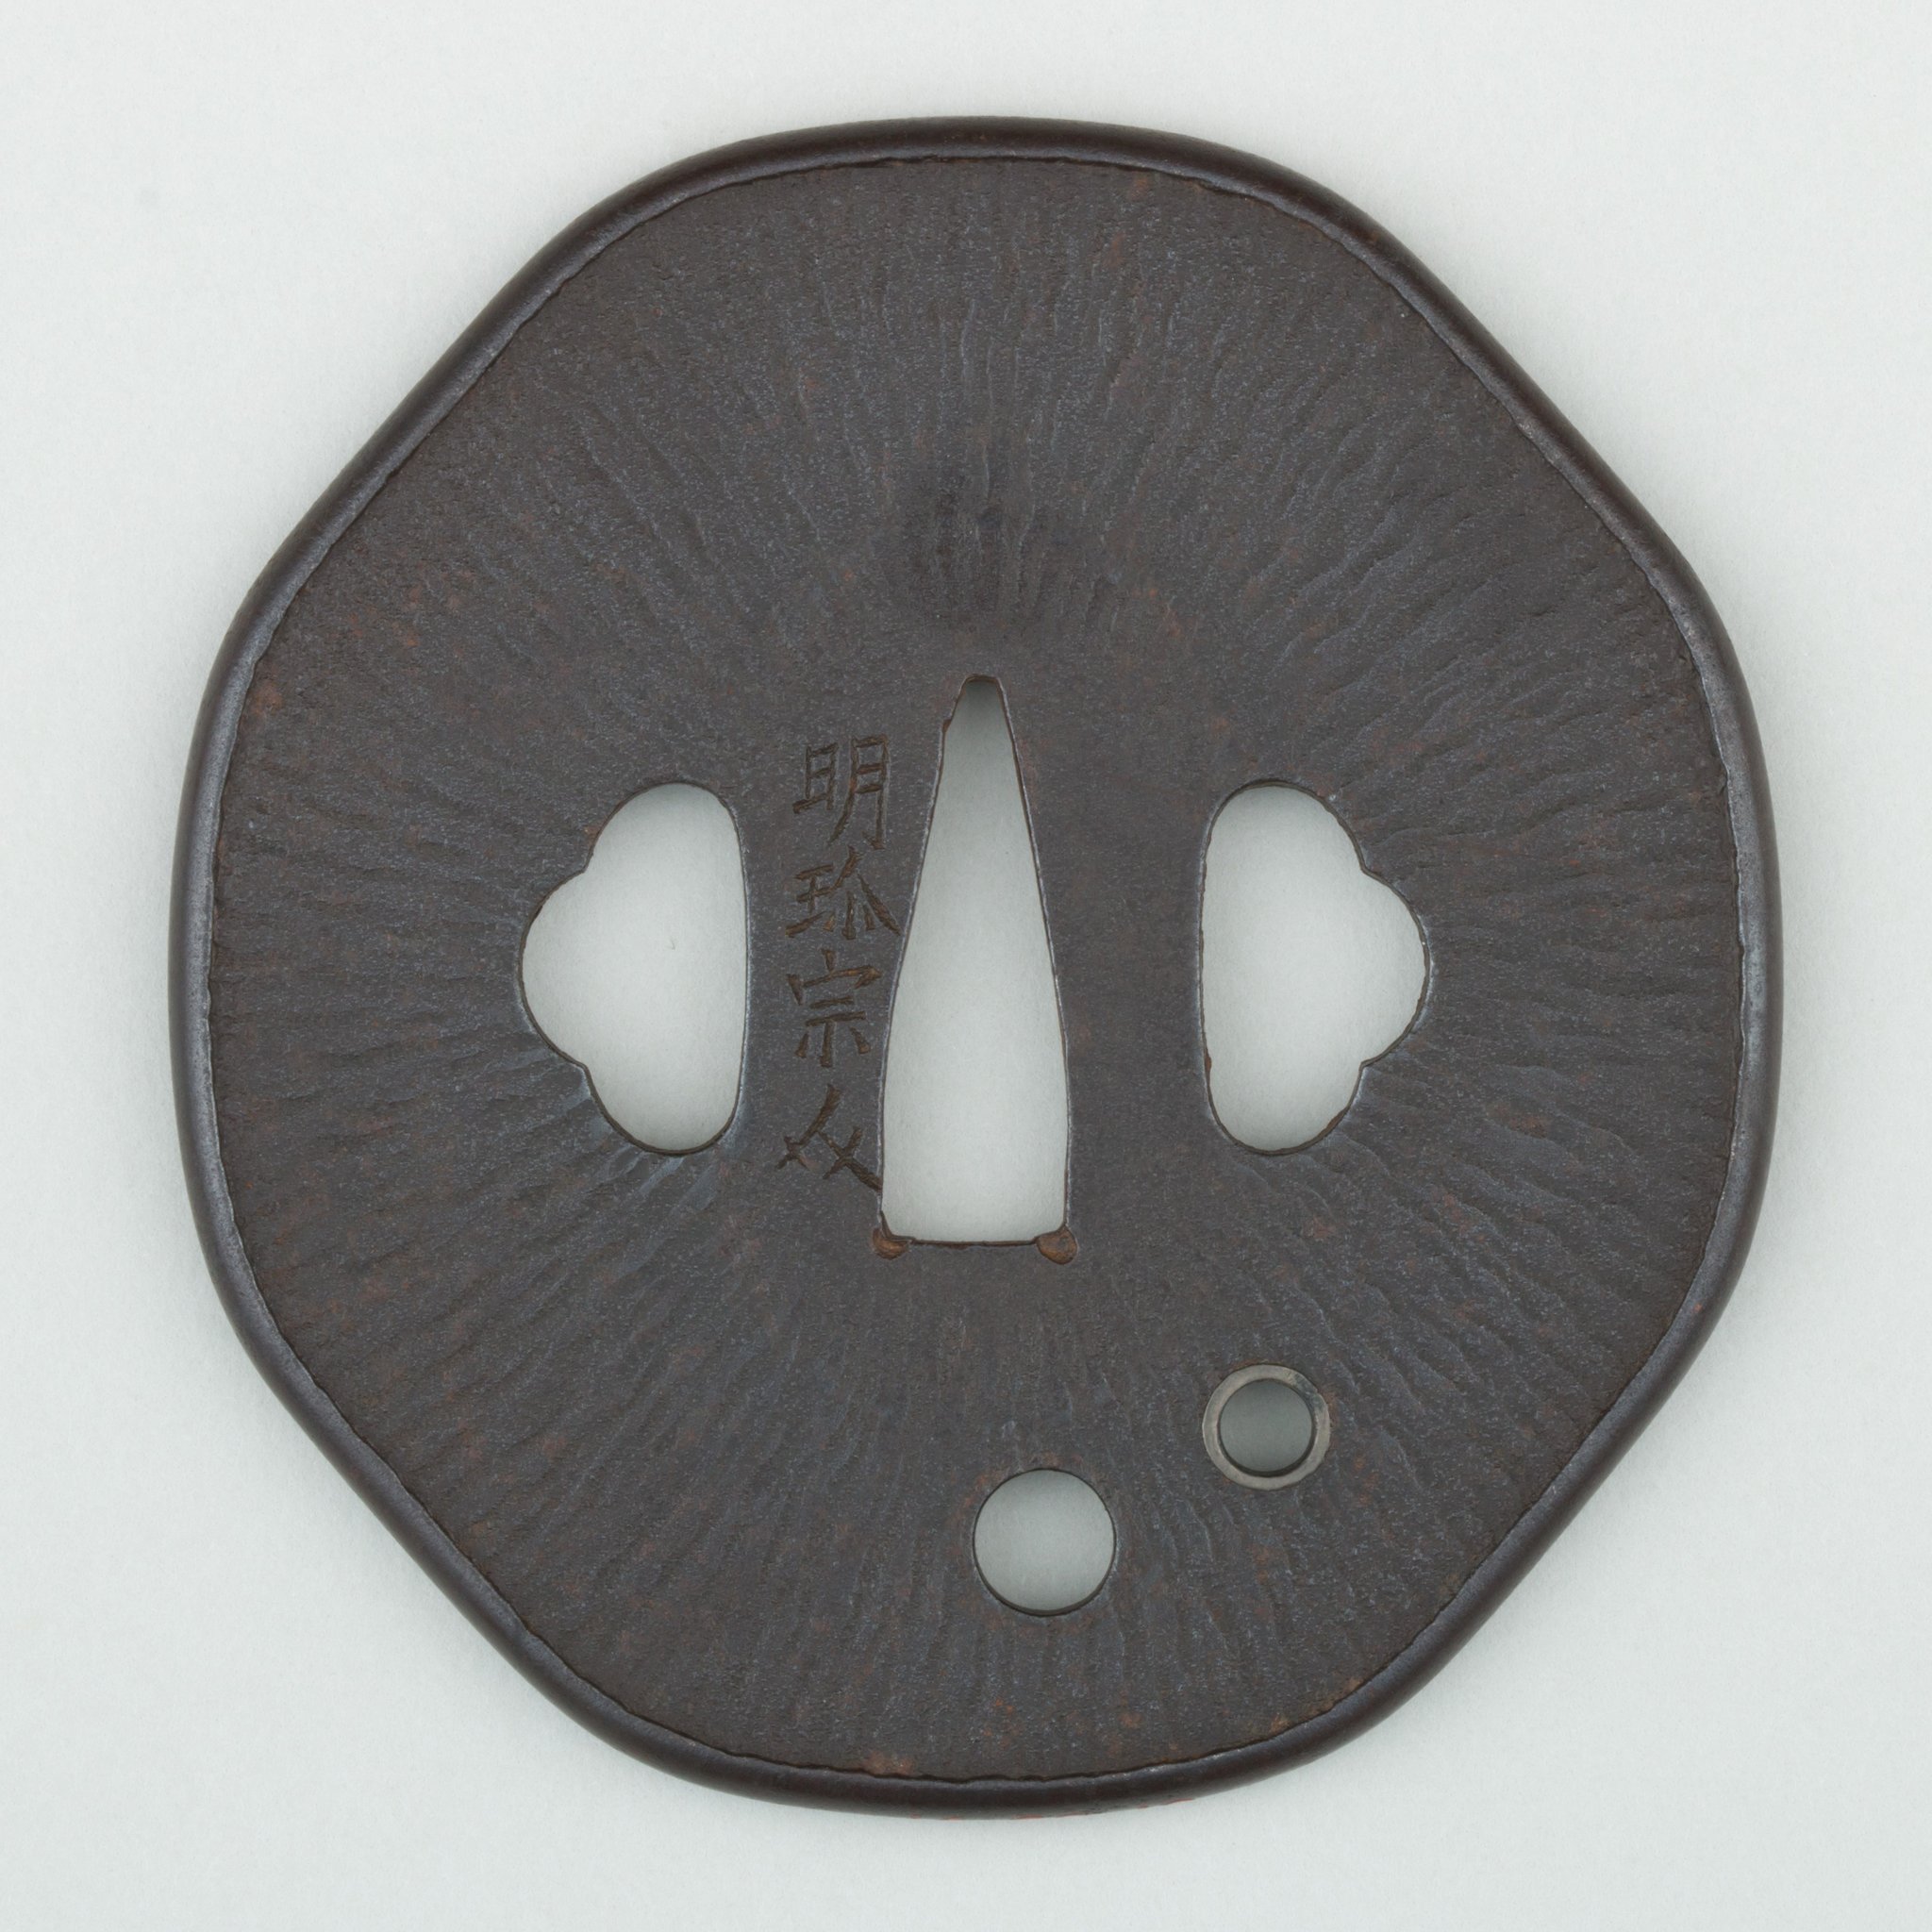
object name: sword guard tsuba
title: Sword Guard (Tsuba)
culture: japanese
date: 1701-1800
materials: copper, iron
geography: japan